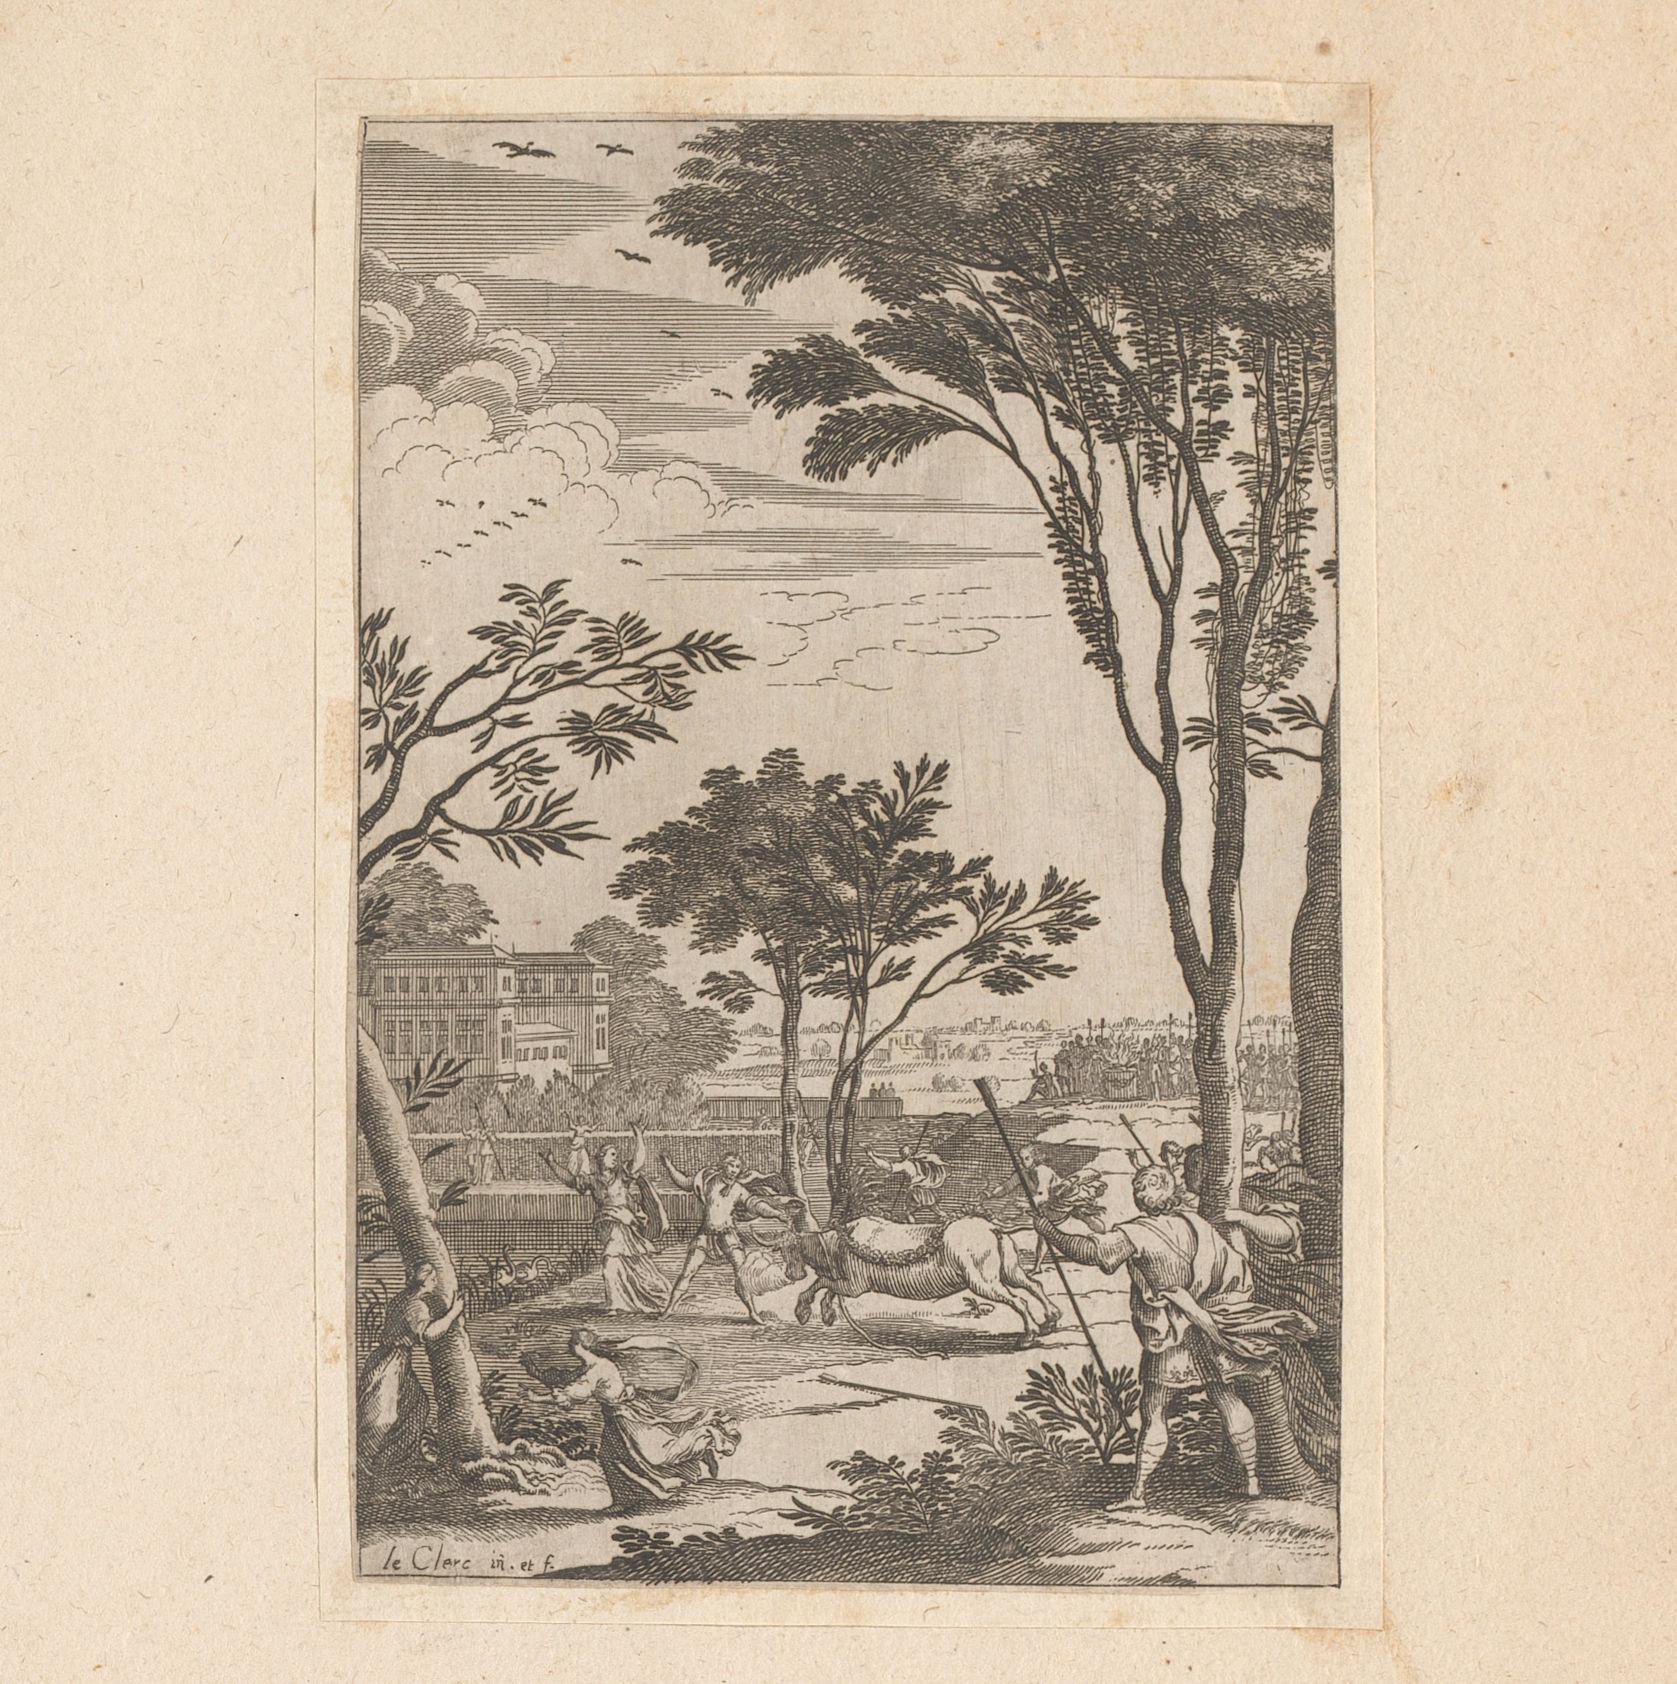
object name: album leaf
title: Ontsnapte offerstier valt een groep herders aan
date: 1667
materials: paper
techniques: etching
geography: paris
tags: bull, herding, herdsman, herdswoman, shepherd, shepherdess, cowherd, etc., animal sacrifice ~ roman religion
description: Prent uit: Du Perret. La Cour d'amour, ou les Bergers galants. Parijs: Thomas Jolly, 1667.